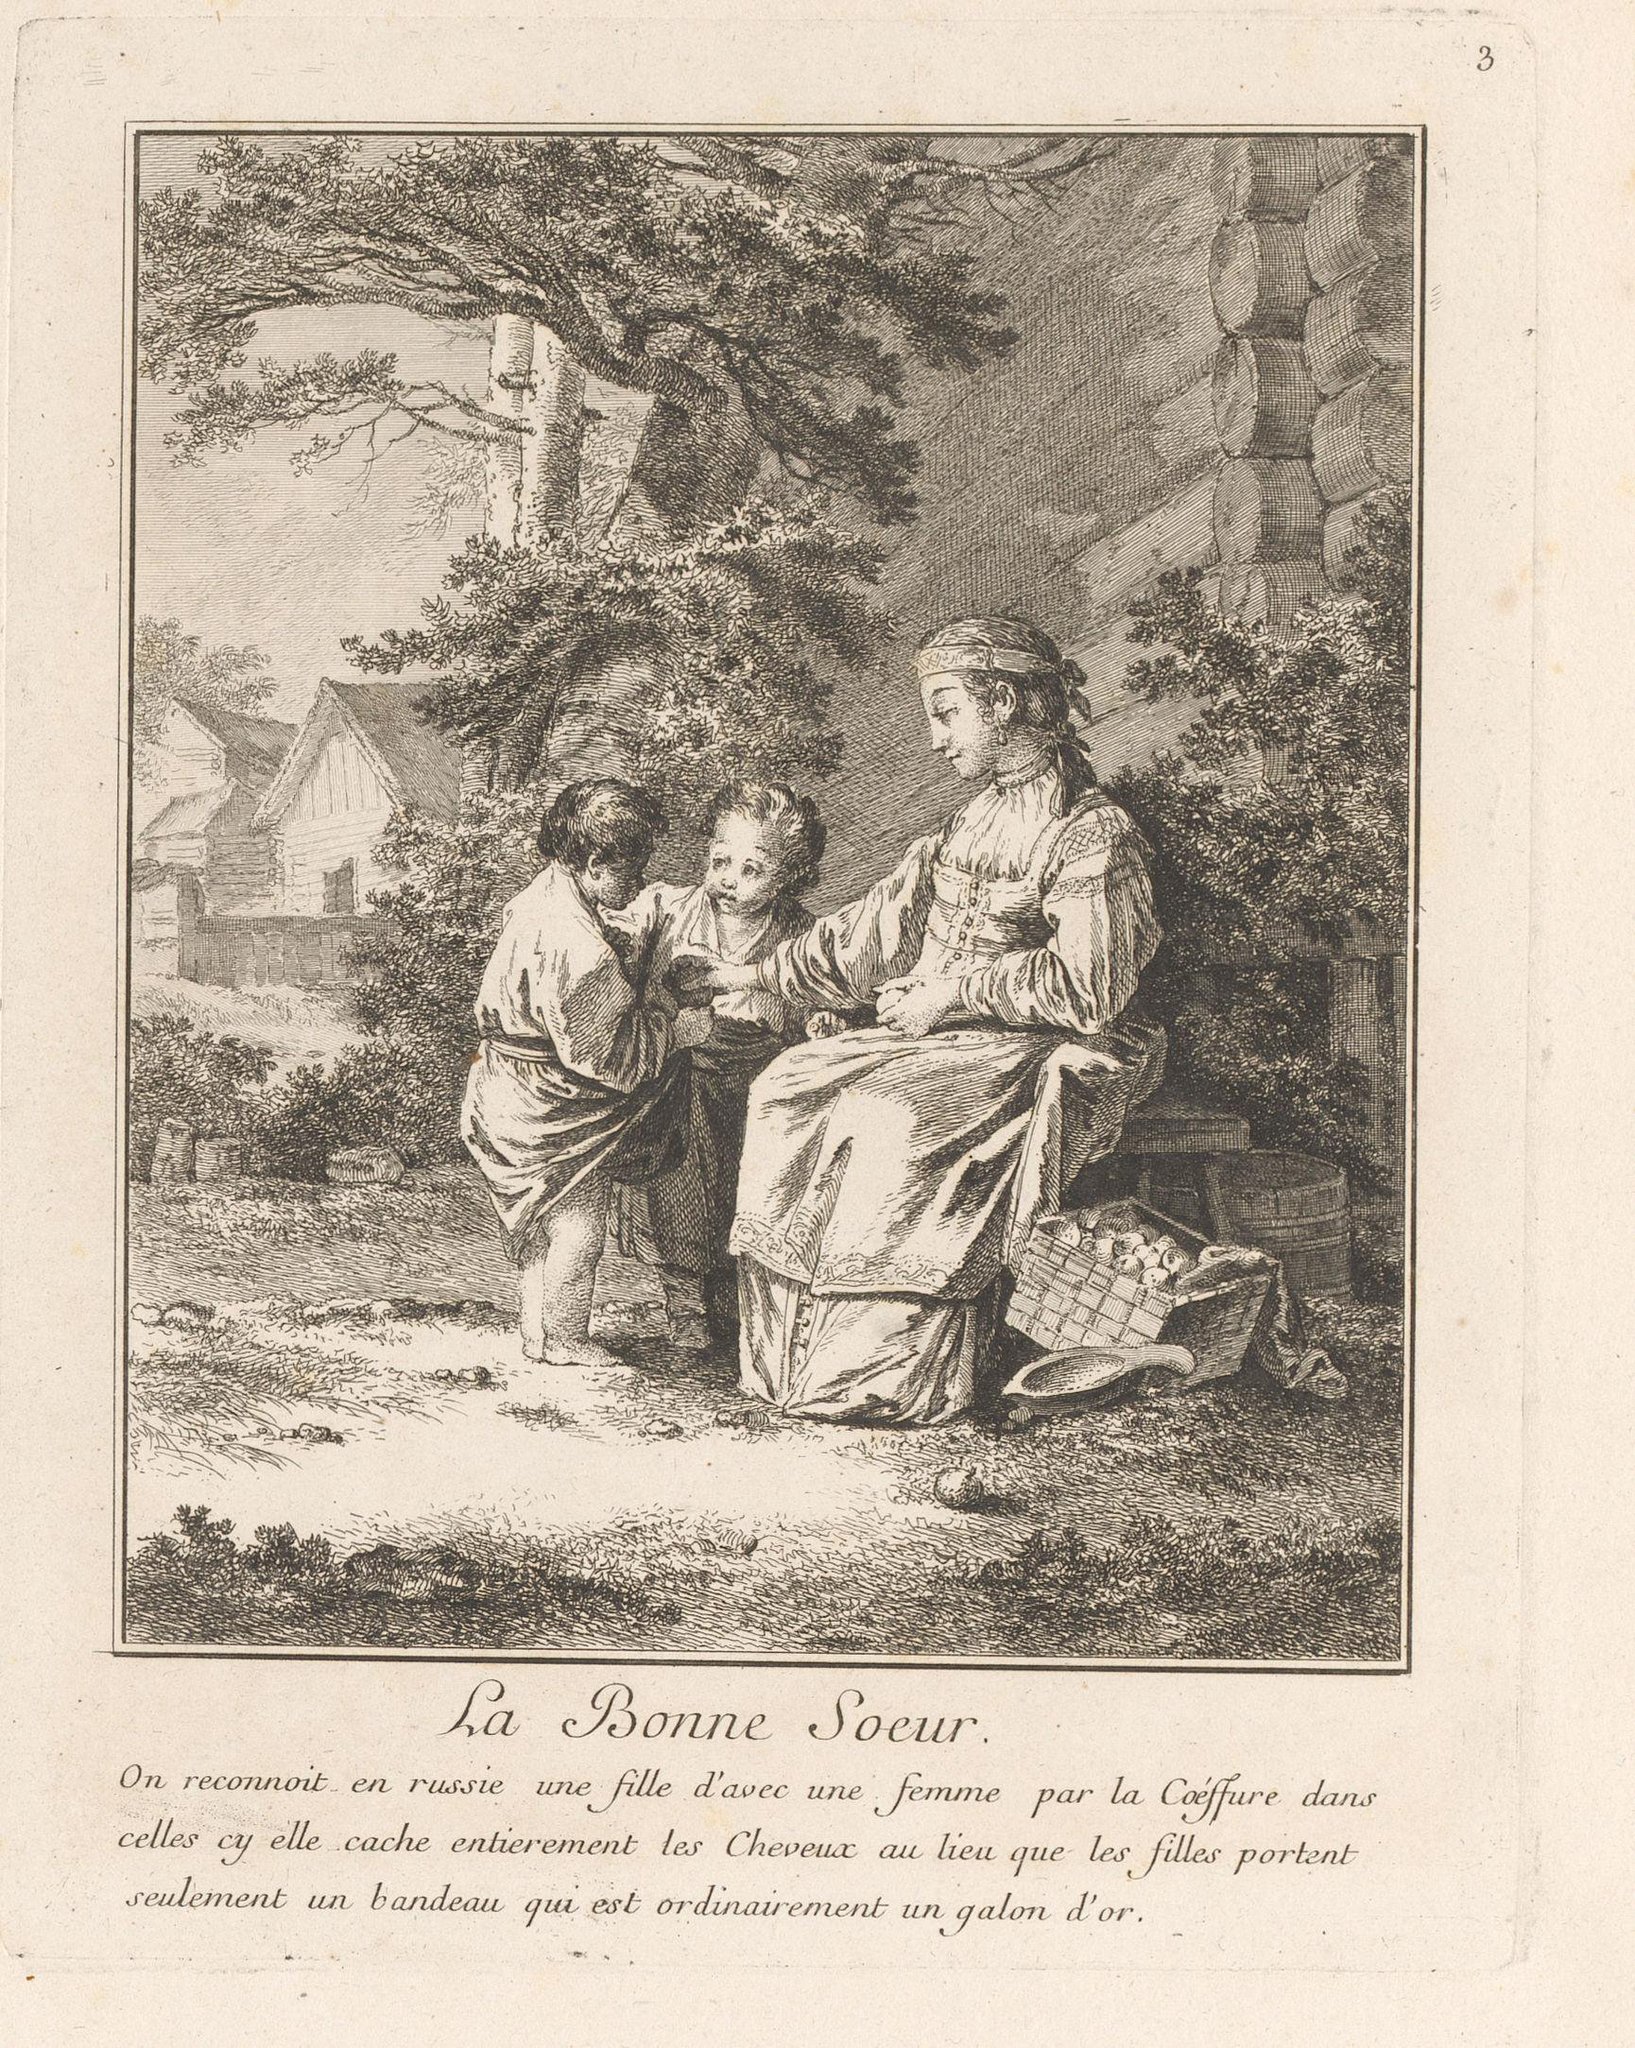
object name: print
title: Jonge vrouw geeft twee kinderen te eten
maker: jean baptist leprince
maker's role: draughtsman, print maker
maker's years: 1734-1781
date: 1764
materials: paper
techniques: etching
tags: brothers or sisters (second degree family relationships)